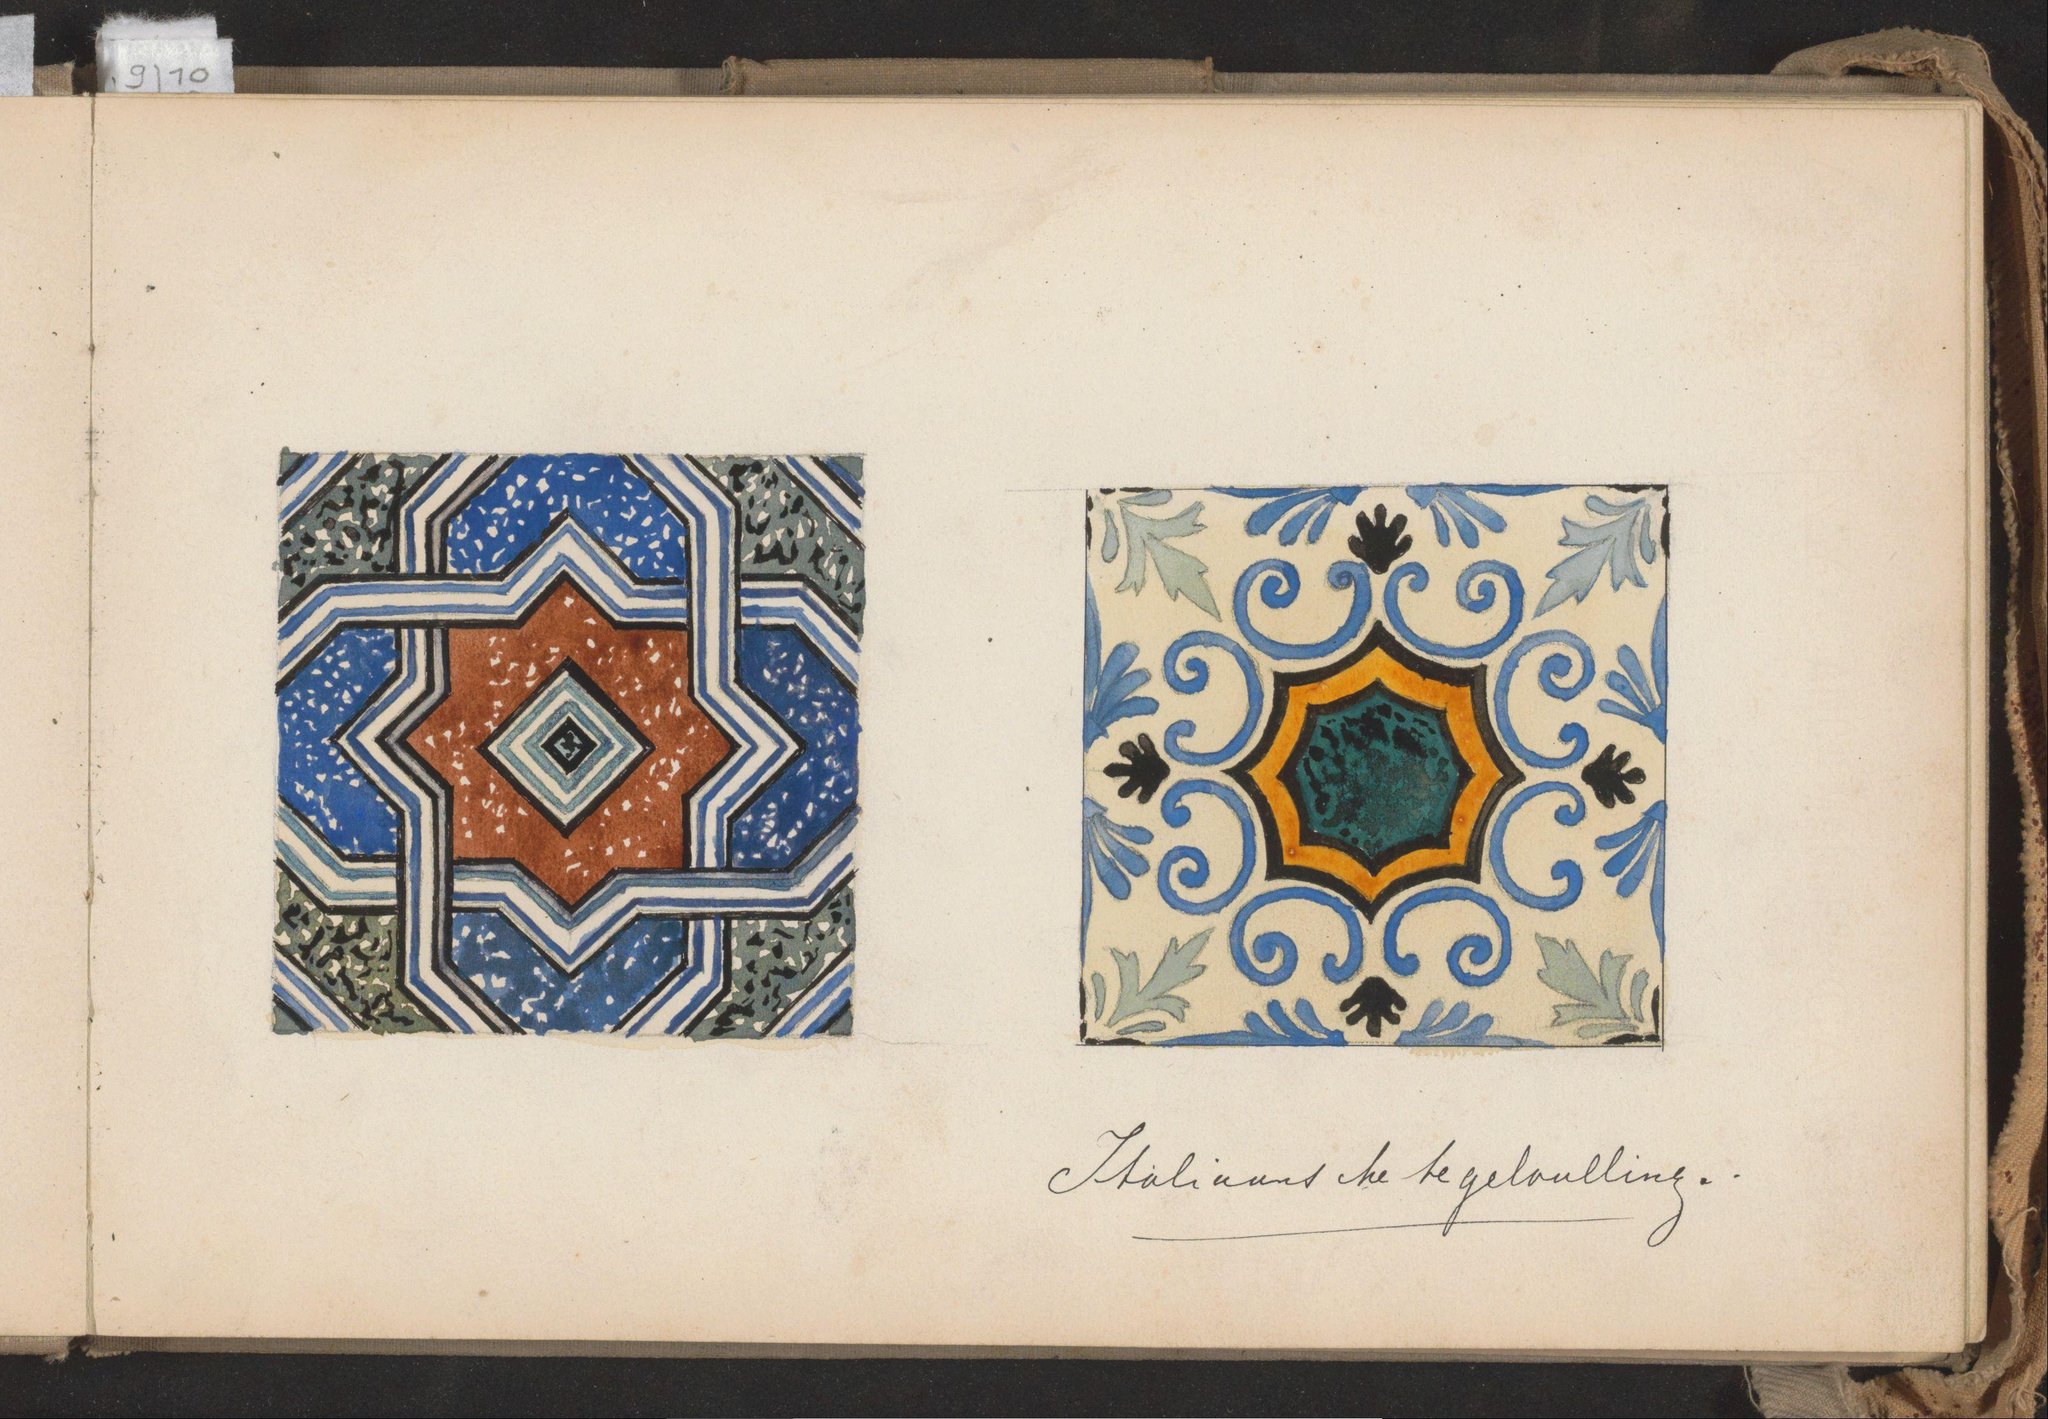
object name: sketchbook leaf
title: Italiaanse tegels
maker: johanna van de kamer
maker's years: 1873-1922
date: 1890-1922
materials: ink, paper, pencil, watercolor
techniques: brush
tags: tiles, bricks ~ building material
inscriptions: annotation: ‘Italiaansche tegelvulling’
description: Blad 6 recto uit een schetsboek met 49 bladen.